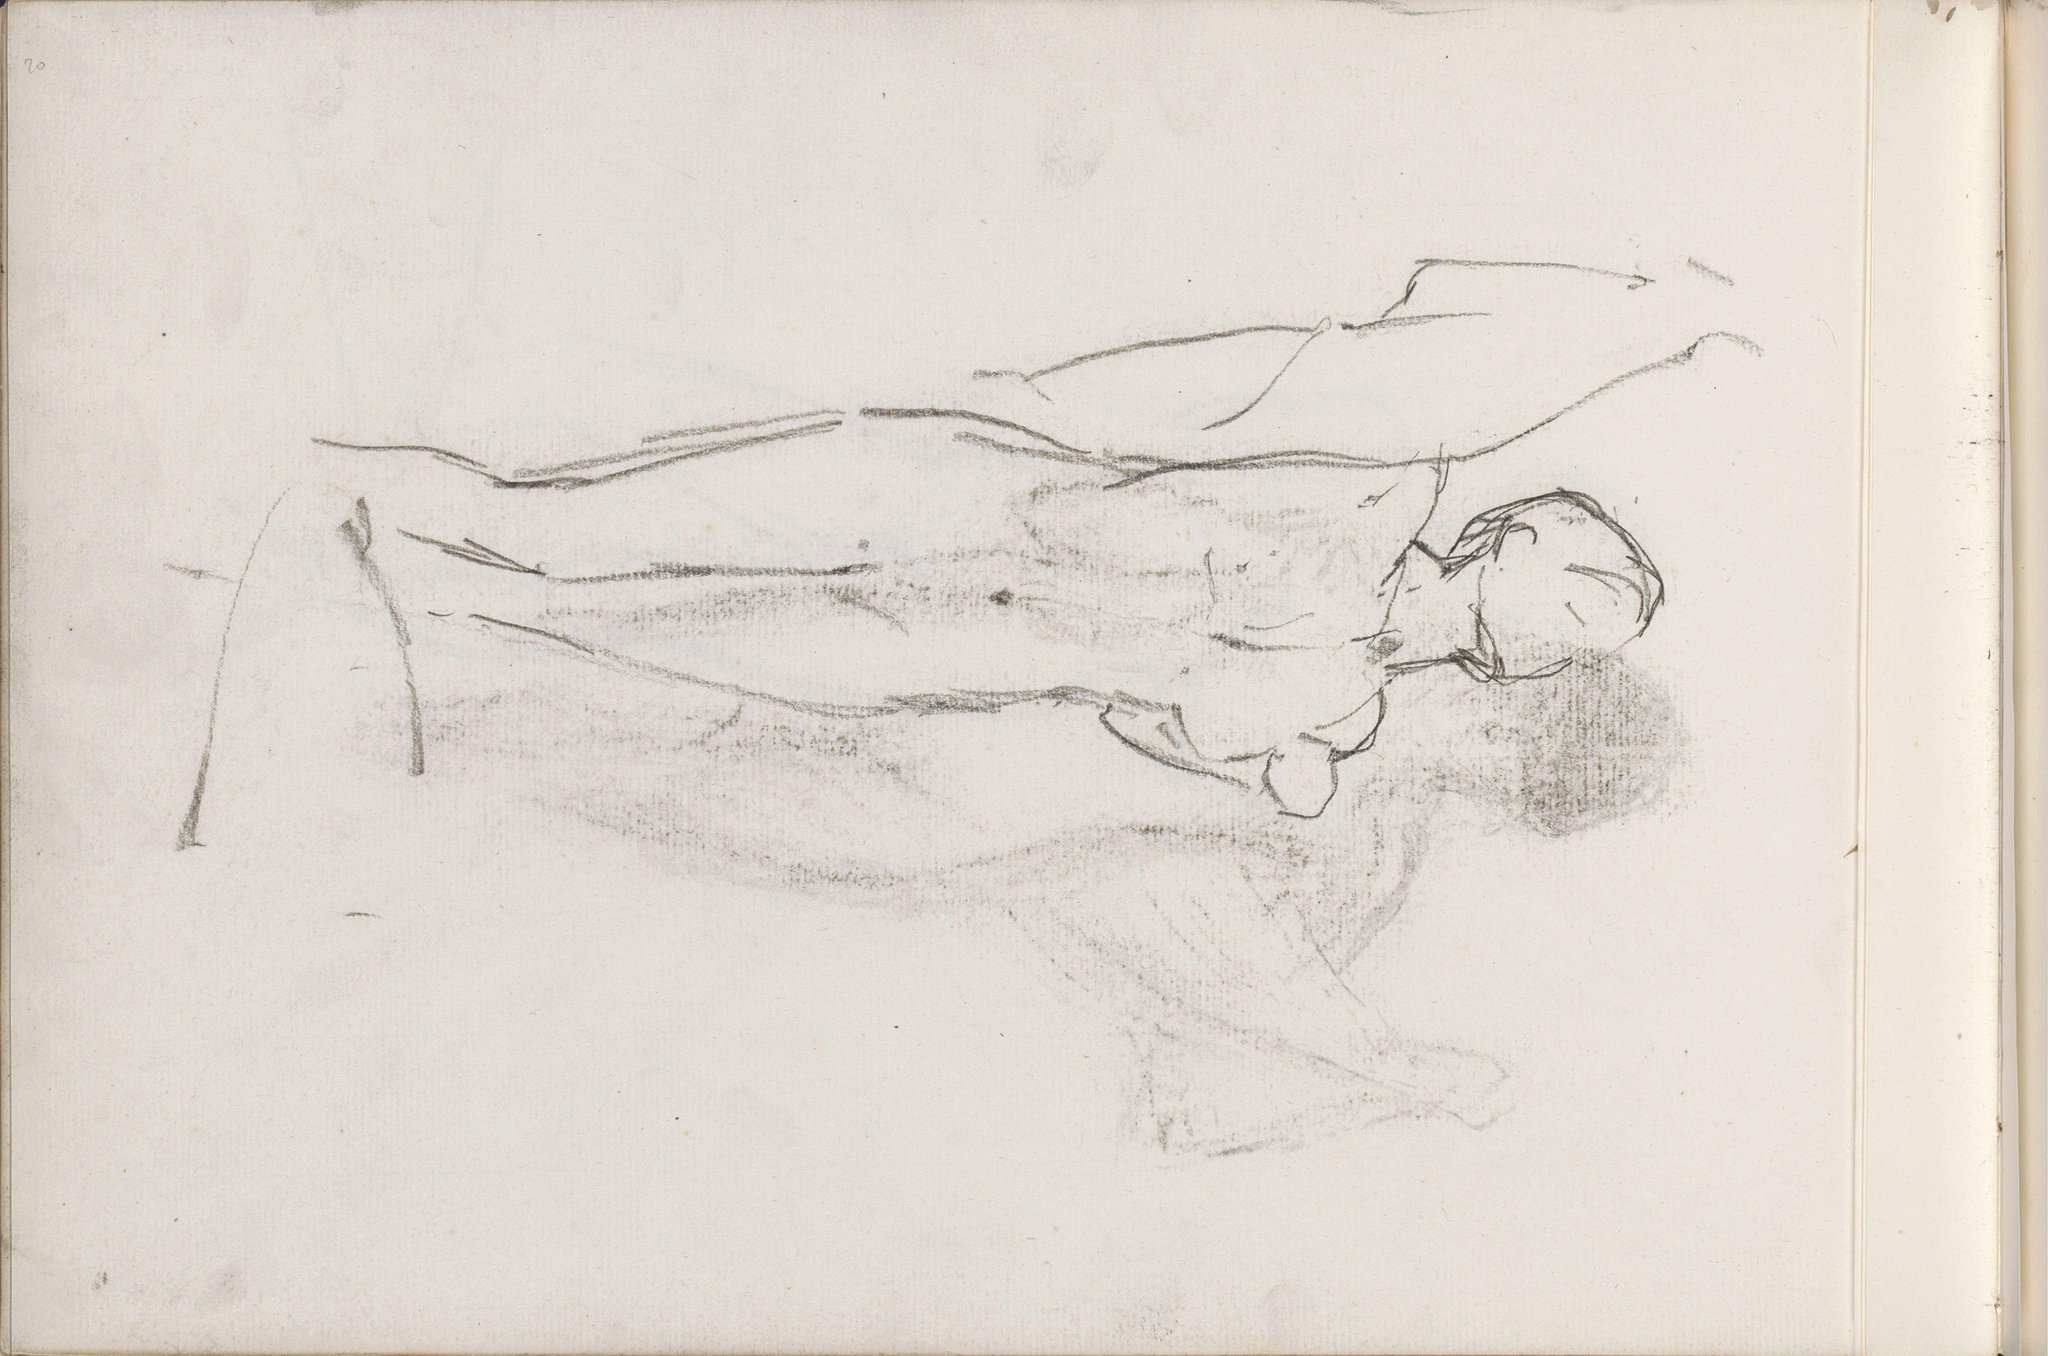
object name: sketchbook leaf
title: Staand vrouwelijk naakt met opgeheven hoofd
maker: willem witsen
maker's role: draughtsman, painter, print maker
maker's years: 1860-1923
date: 1887-1892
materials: chalk, paper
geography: amsterdam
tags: the (nude) human figure; 'corpo humano' (ripa) - aa - female human figure (+ standing)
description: Pagina 20 uit een schetsboek met 17 bladen.